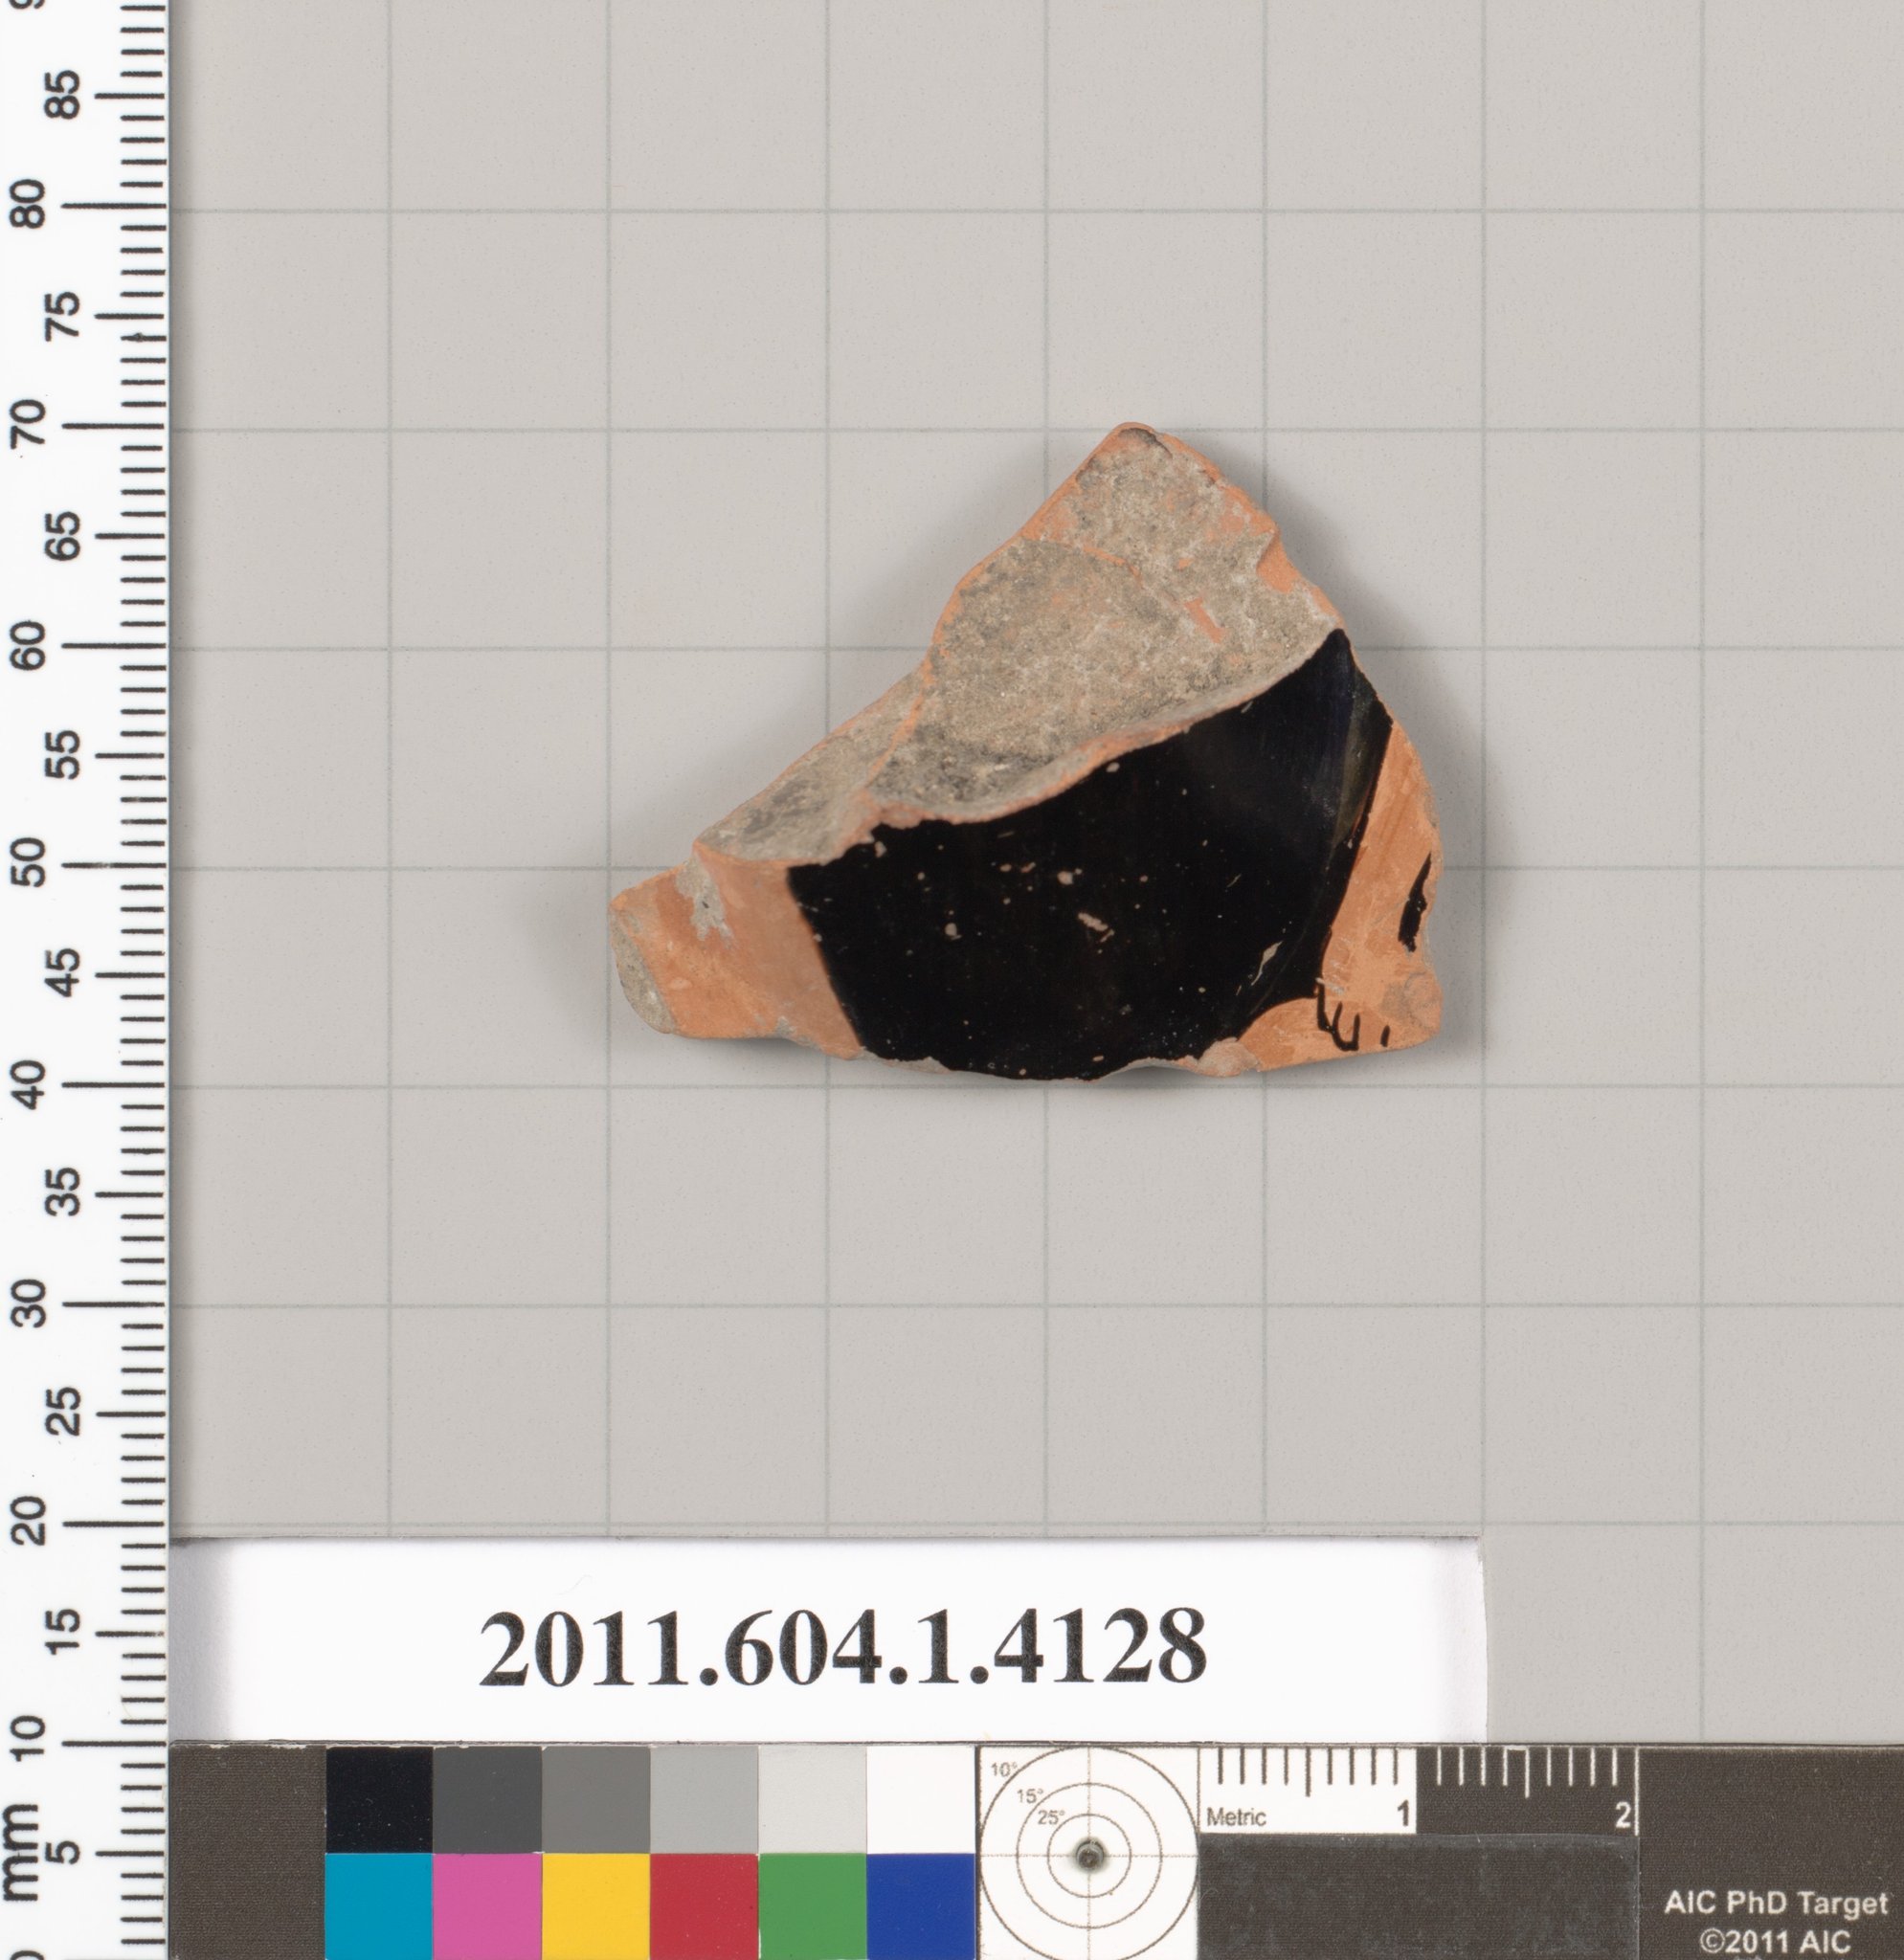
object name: kylix fragment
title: Terracotta fragment of a kylix (drinking cup)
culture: greek, attic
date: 490-470 BCE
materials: terracotta